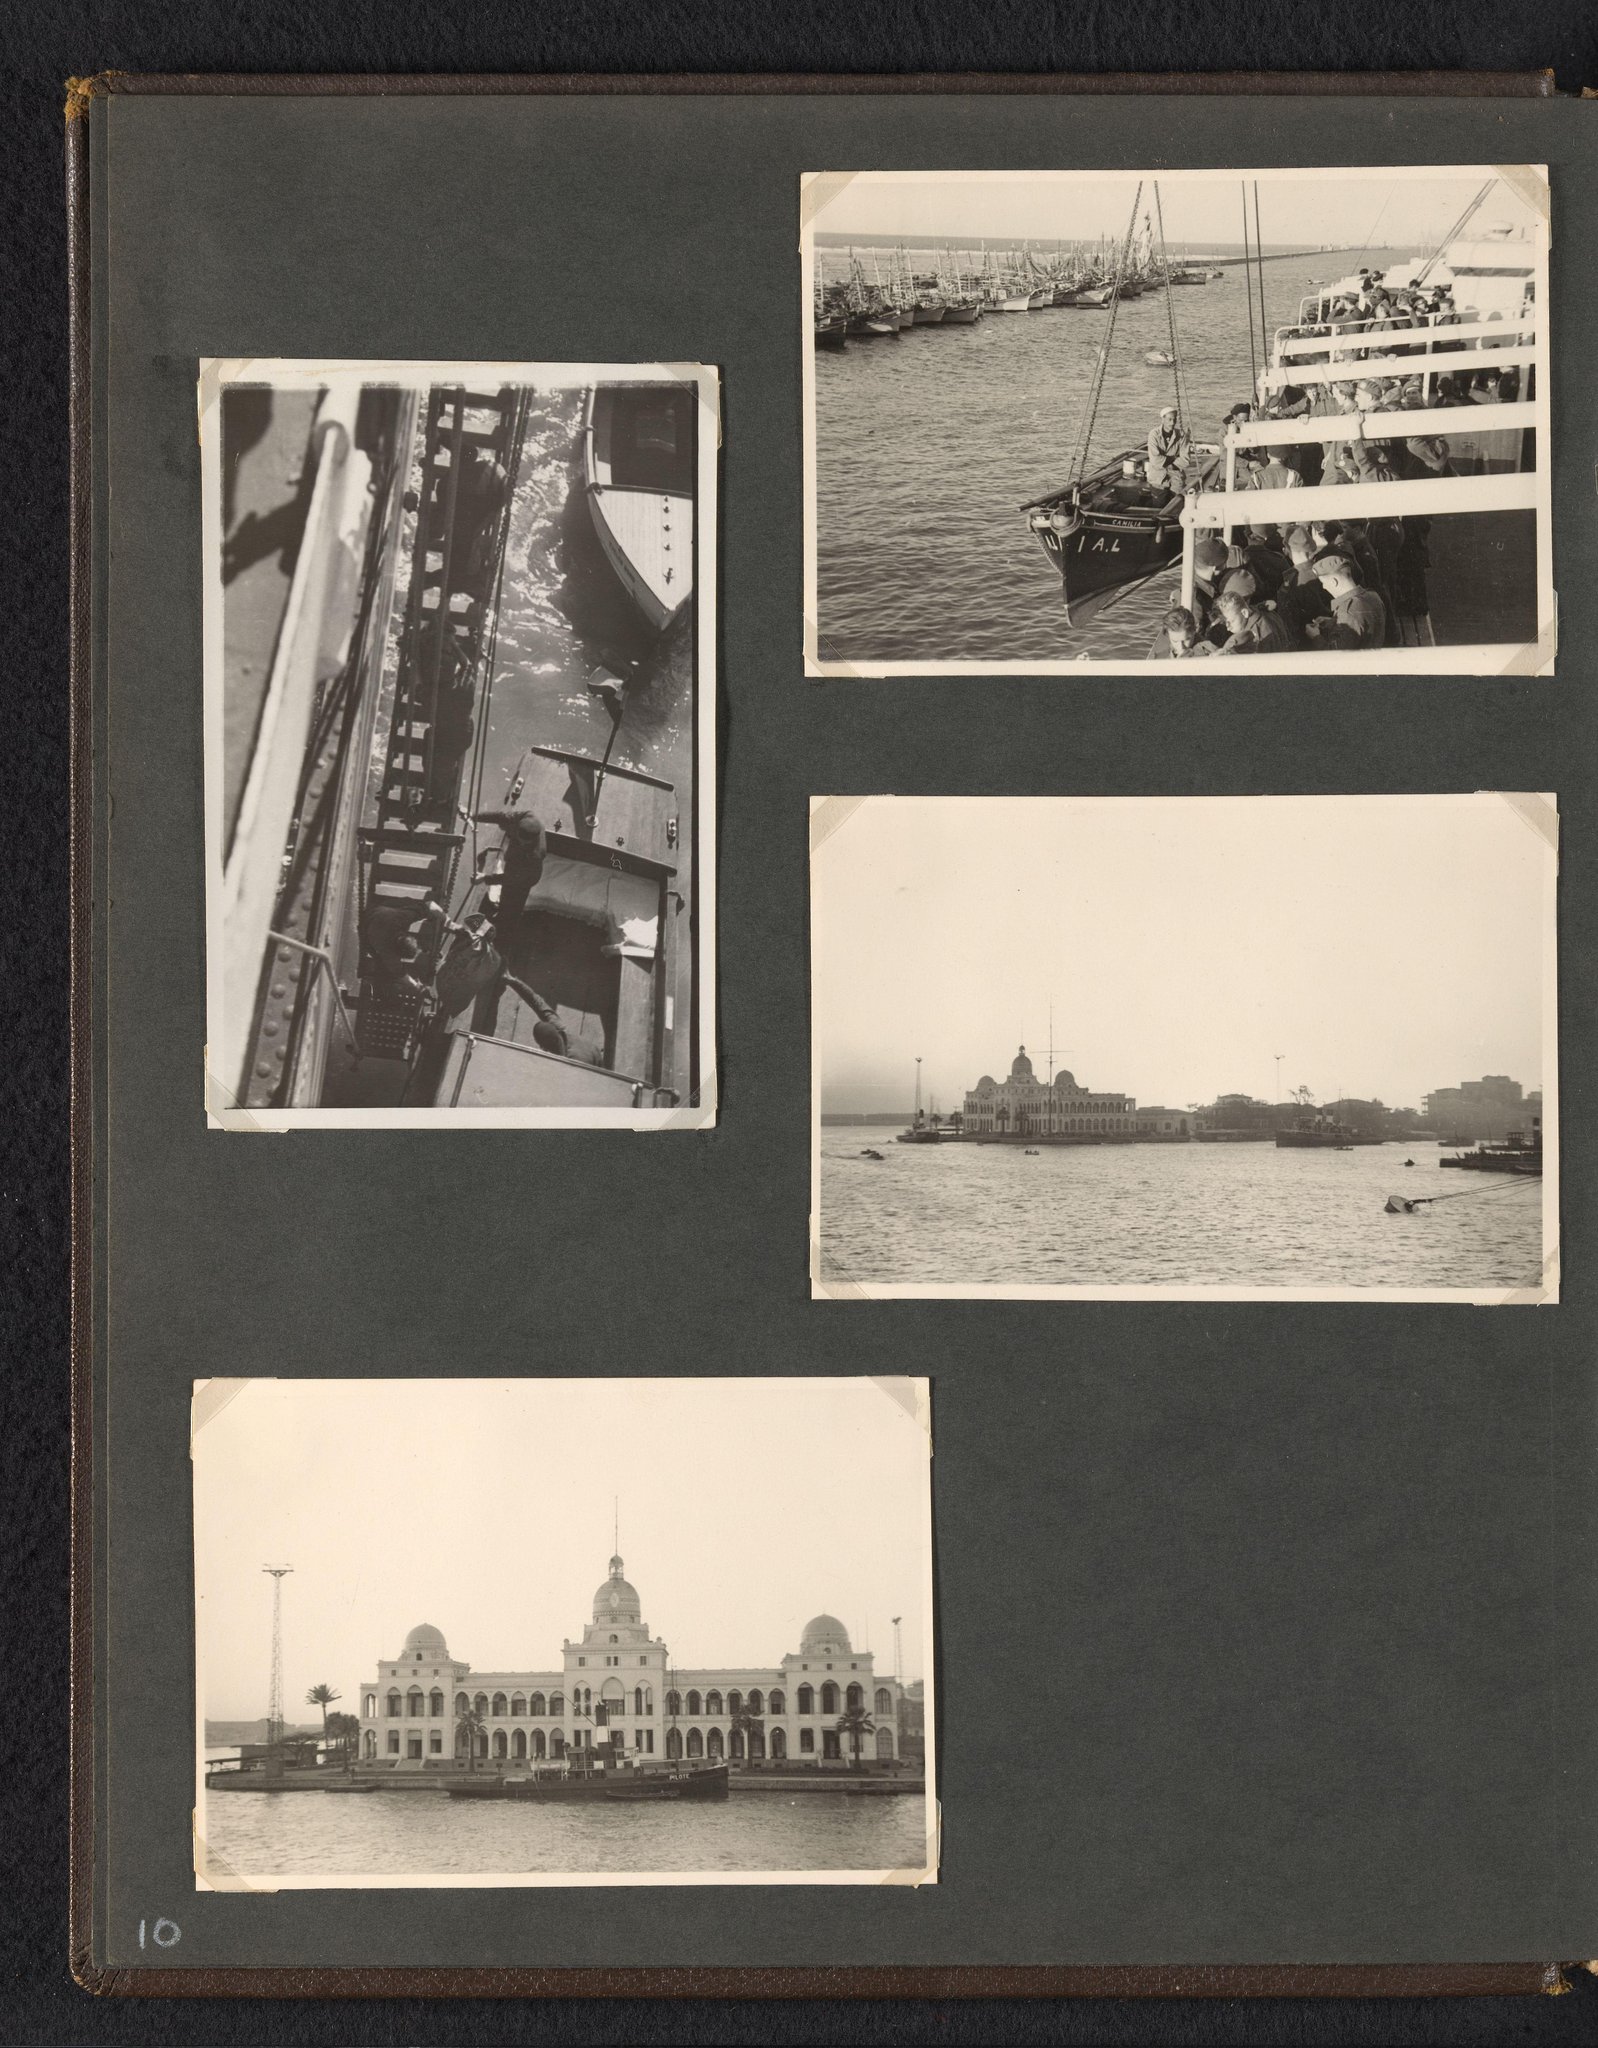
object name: photograph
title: Port Said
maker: Anonymous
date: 1947-1948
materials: cardboard, photographic support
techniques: gelatin silver print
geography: port said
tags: troop movements, transportation, rowing-boat, canoe, etc., steamship, motorship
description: Albumblad met vier foto's van het gebouw van de Suez Canal Authority in Port Said en van Egyptische bootjes langszij, genomen vanaf de S.S. Waterman op weg naar Nederlands-Indië. Onderdeel van het fotoalbum 'Mijn jaren in Indië' met foto's over de militaire acties in Nederlands-Indië.